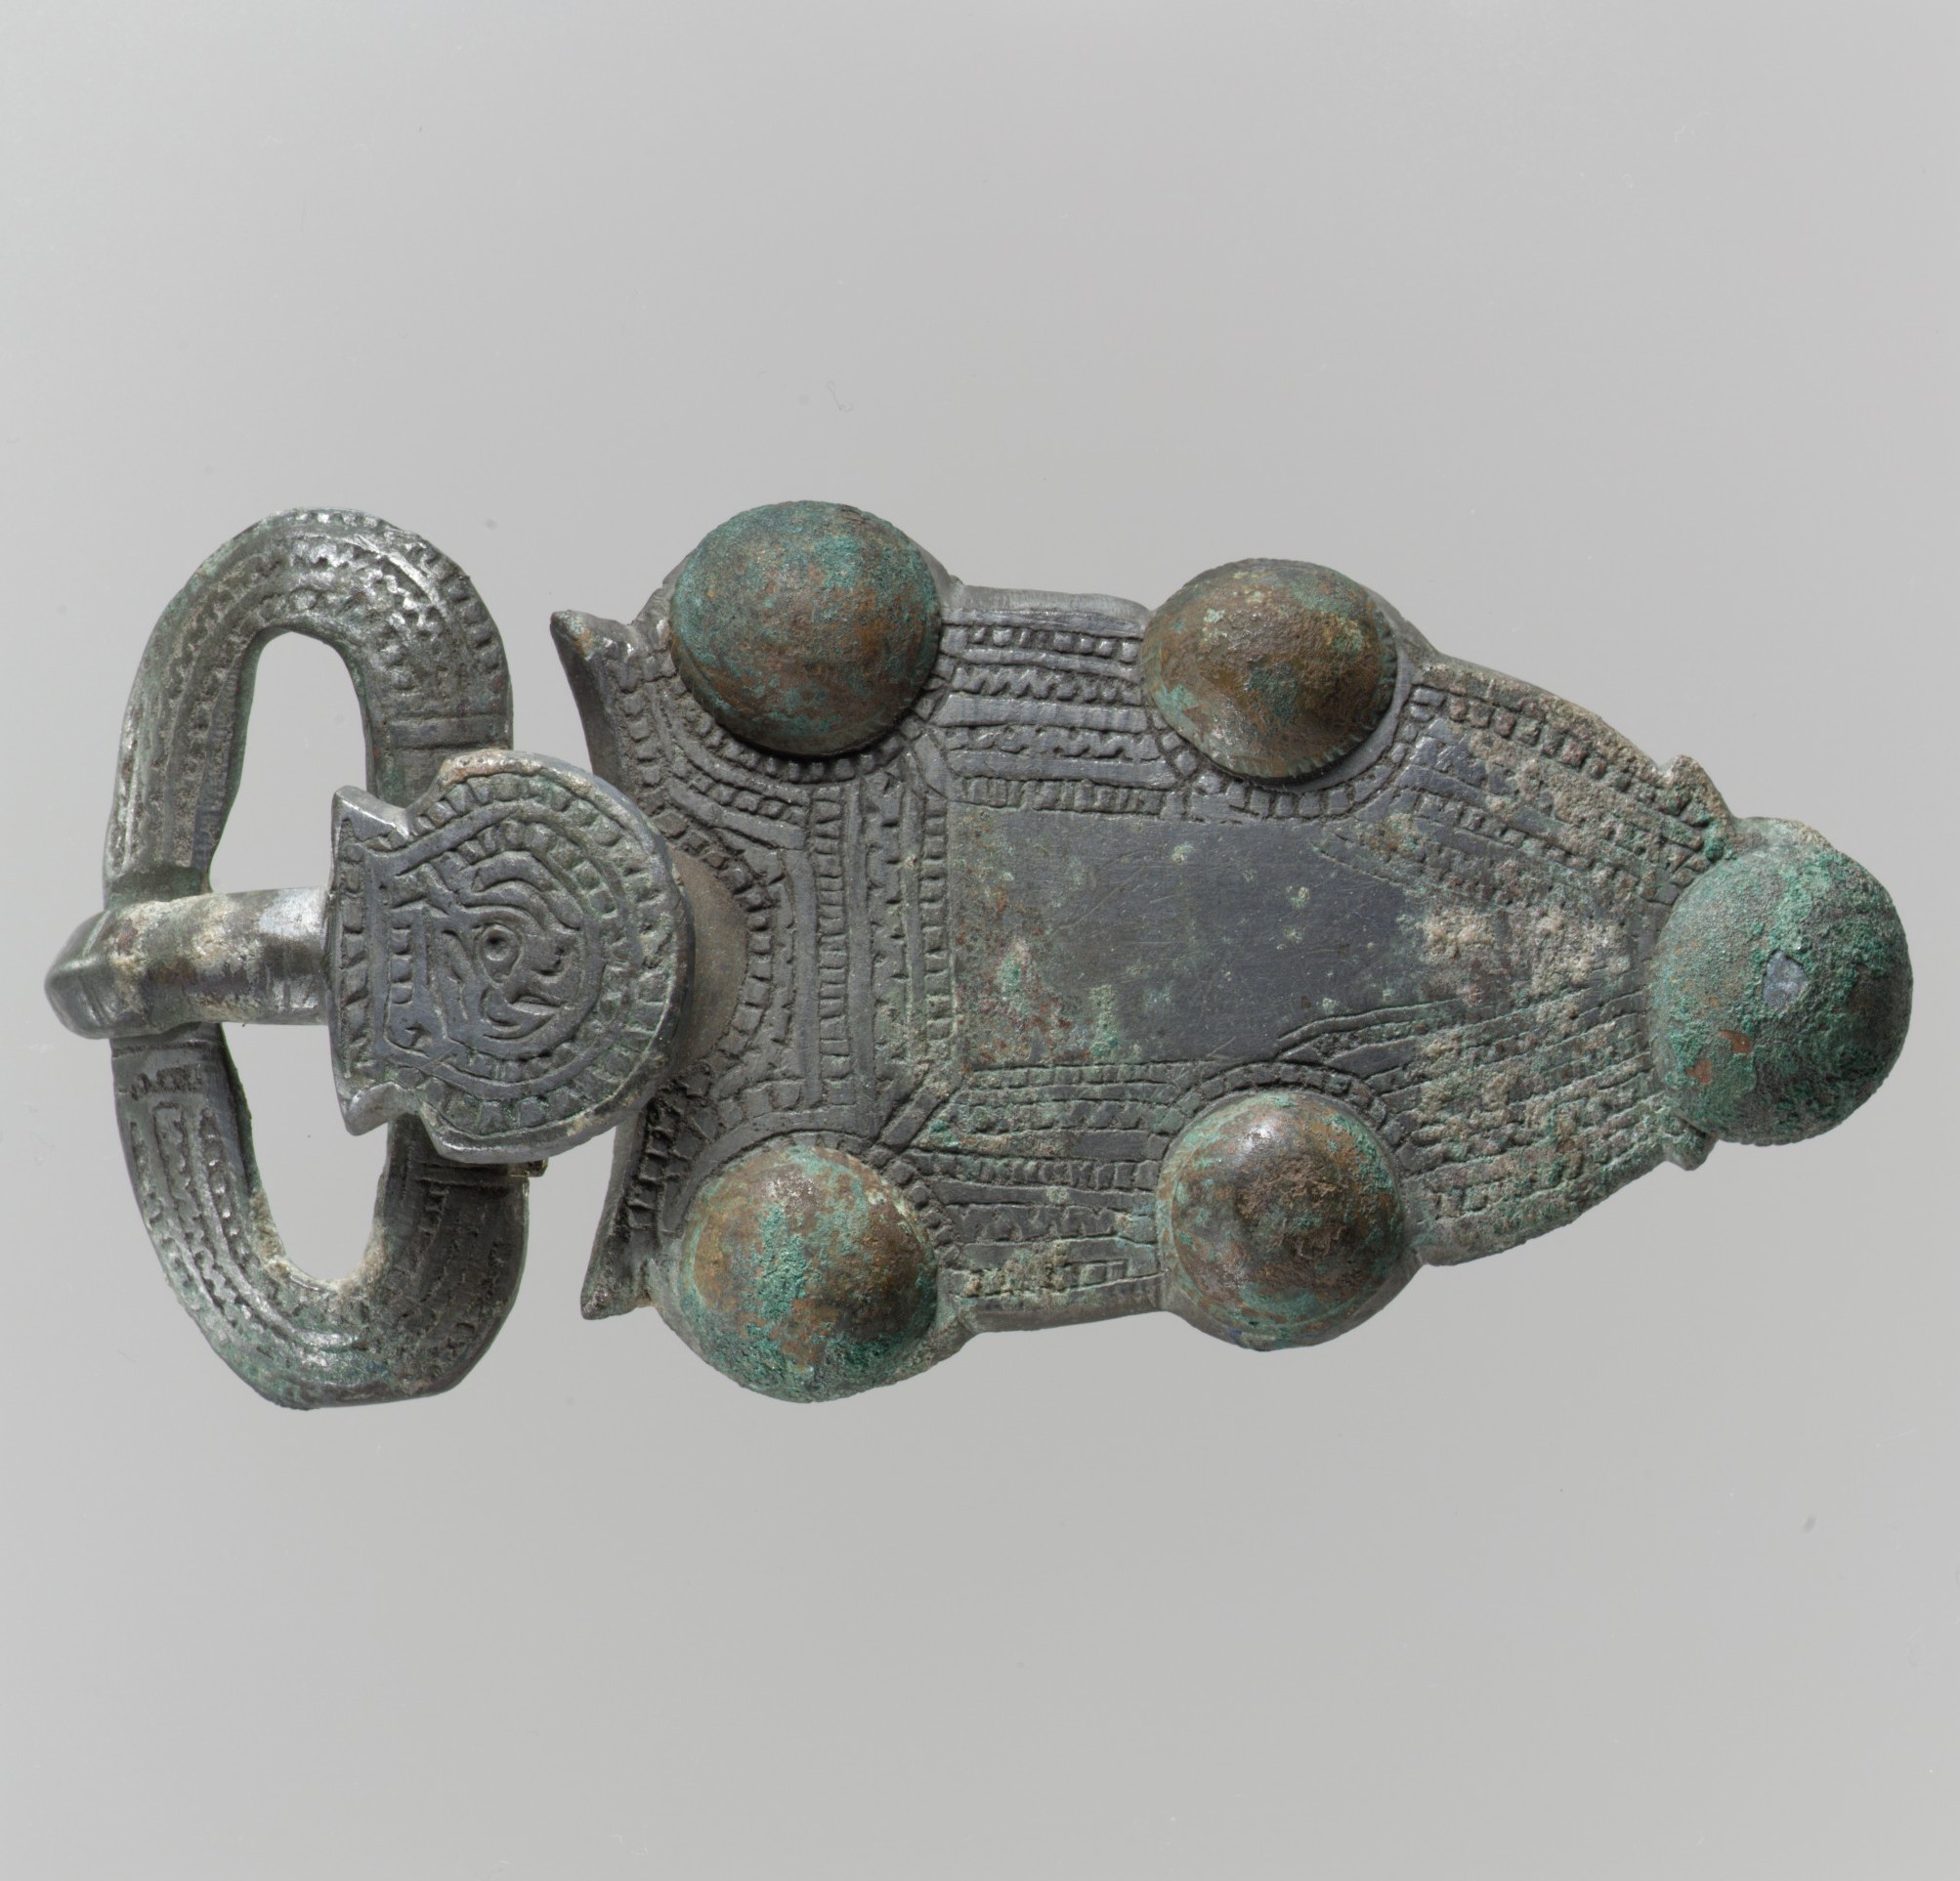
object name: belt buckle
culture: frankish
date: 601-700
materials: copper alloy